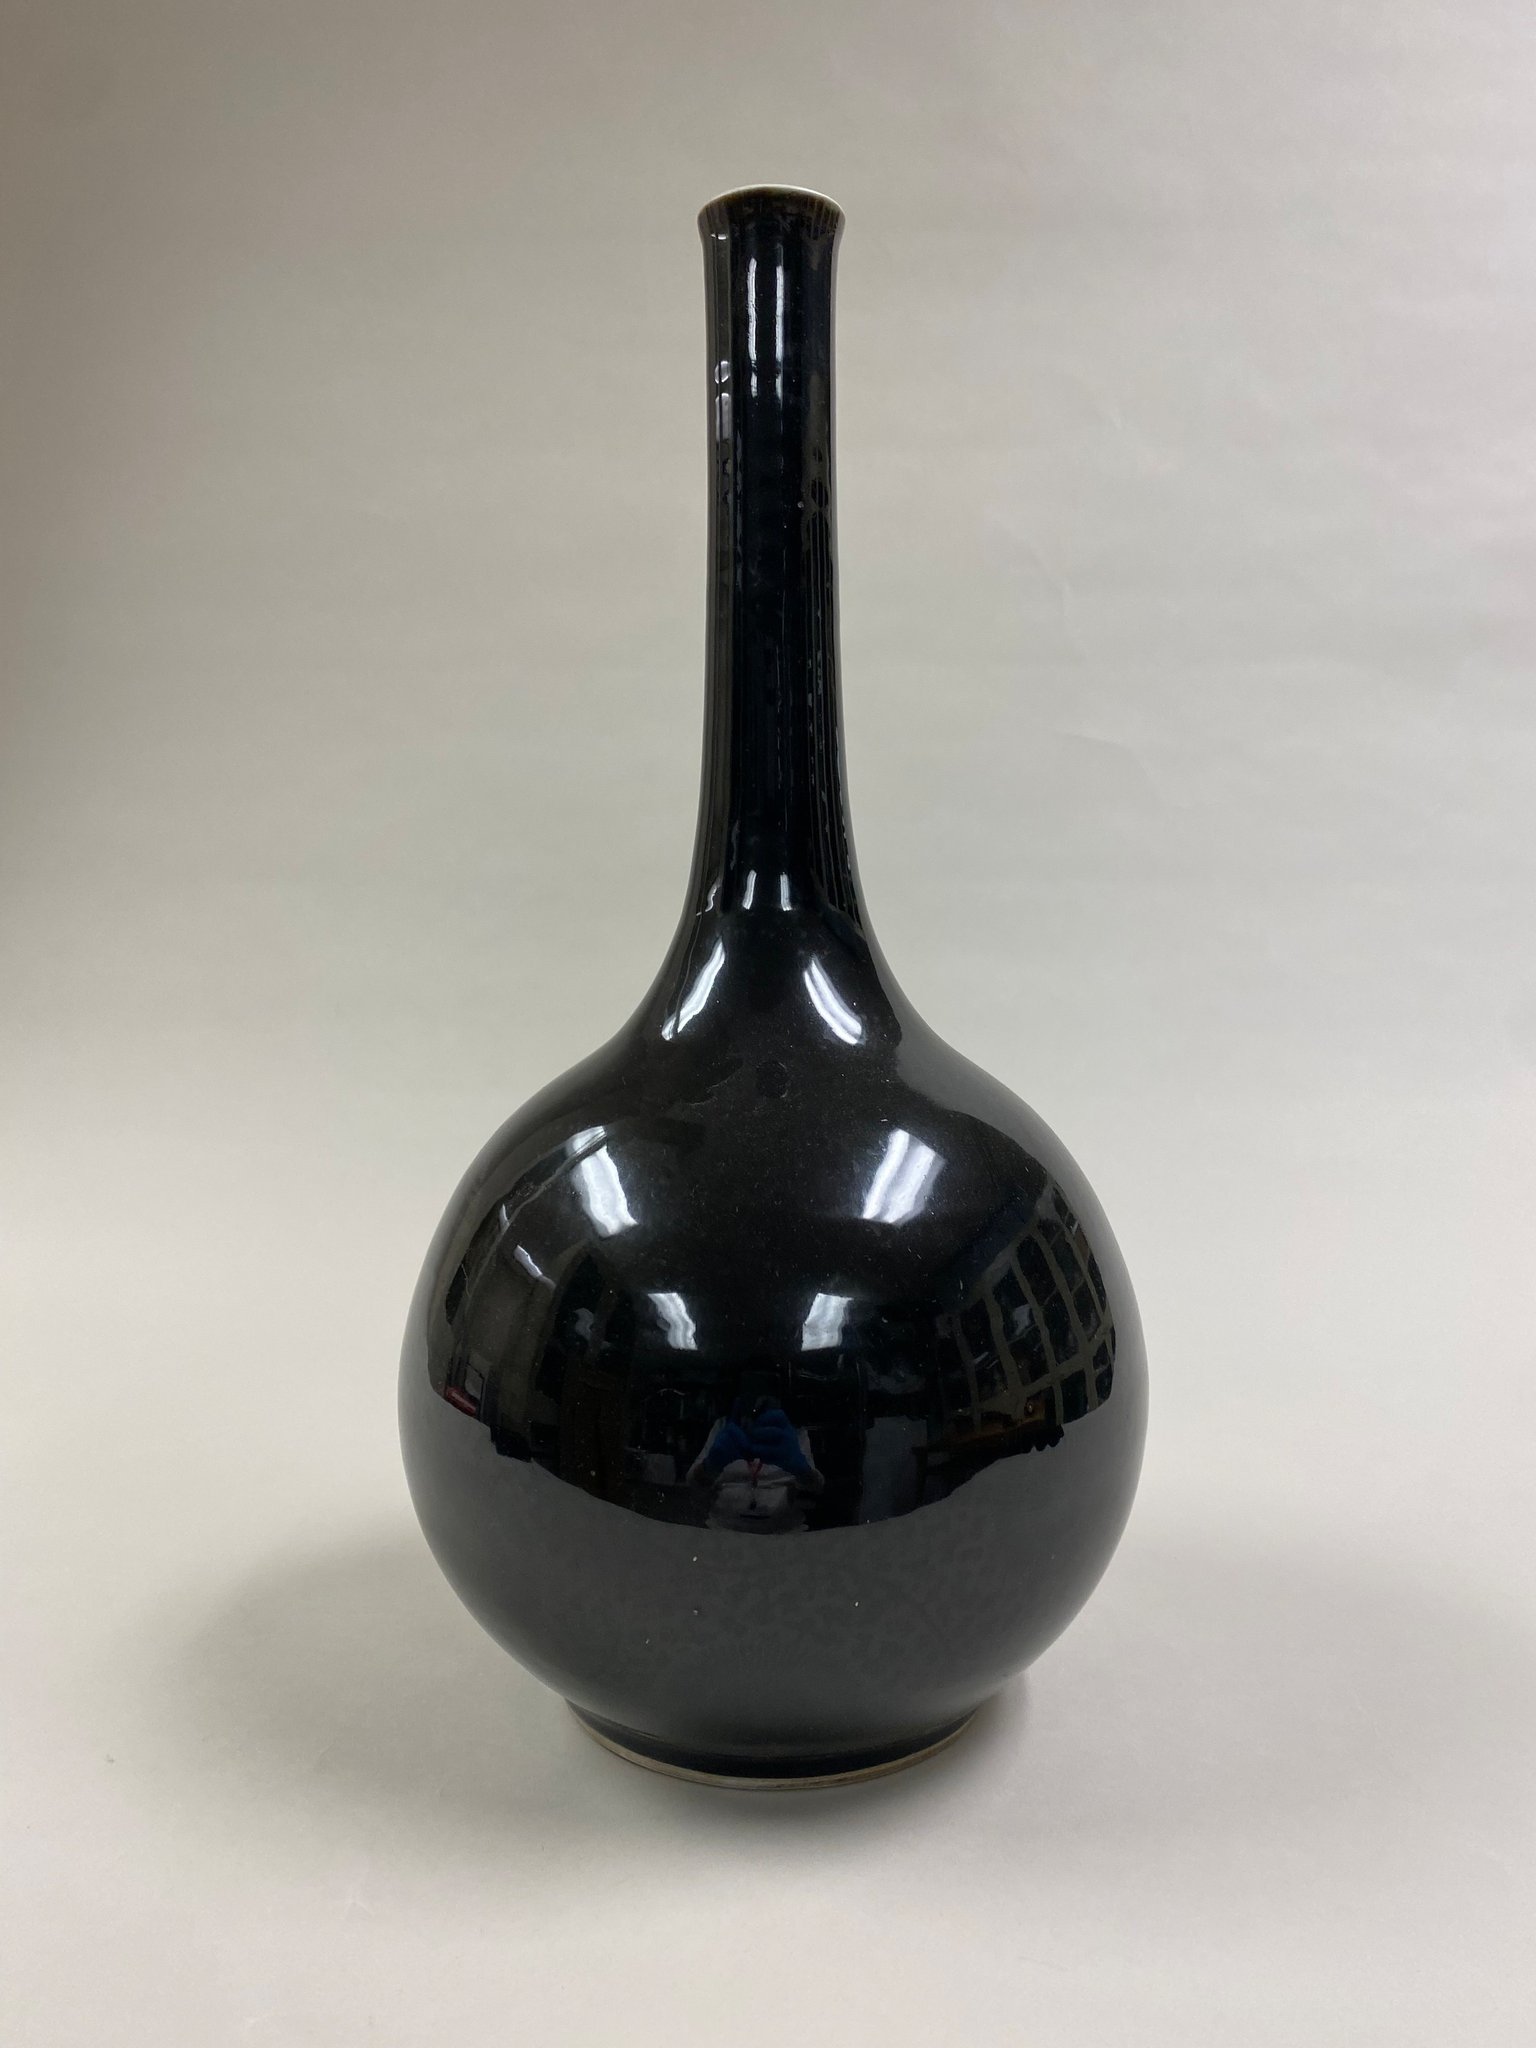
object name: vase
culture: chinese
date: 1667-1733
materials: glaze, porcelain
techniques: gilding